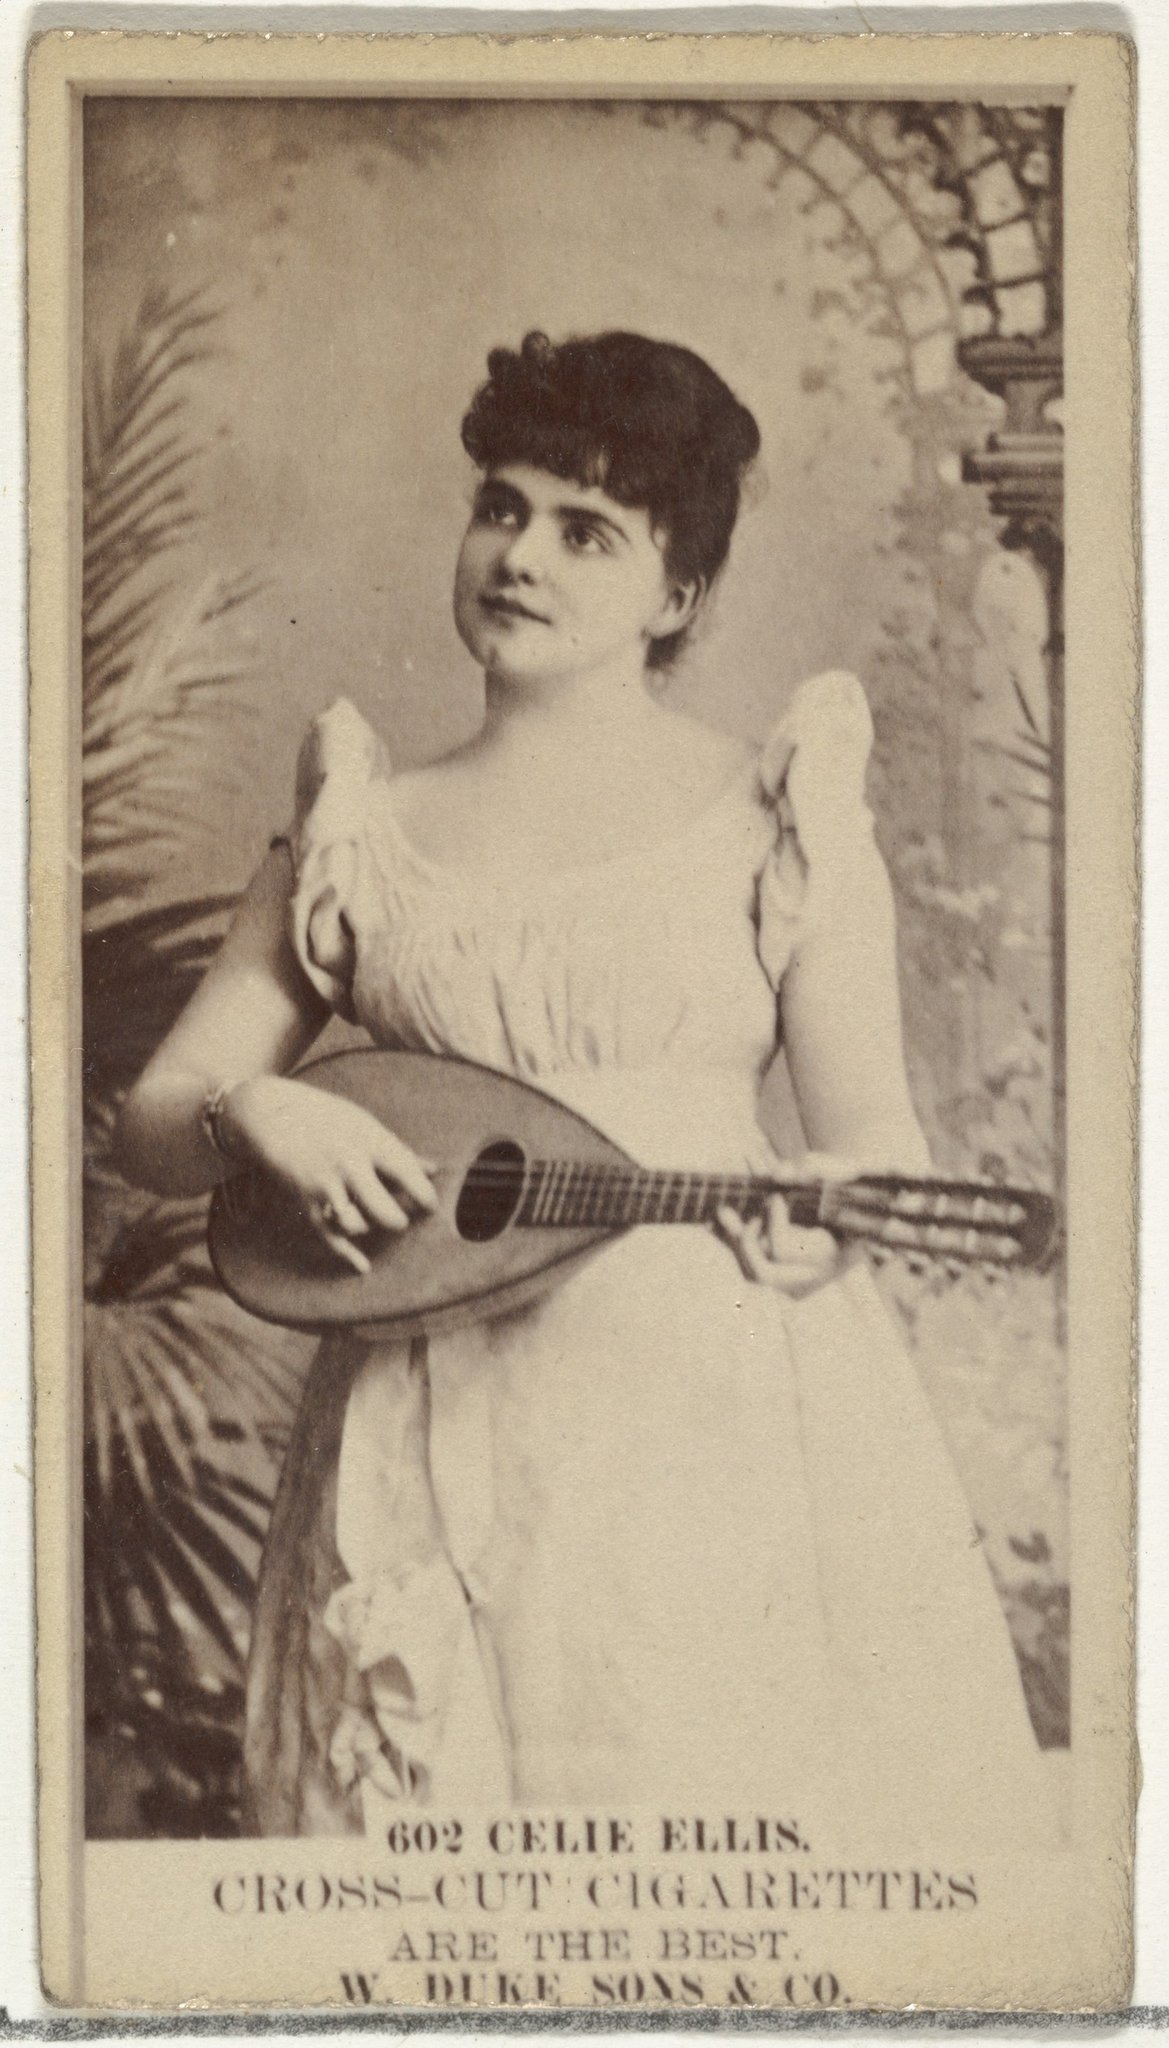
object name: photograph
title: Card Number 602, Celia Ellis, from the Actors and Actresses series (N145-3) issued by Duke Sons & Co. to promote Cross Cut Cigarettes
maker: w. duke, sons & co.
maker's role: publisher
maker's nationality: american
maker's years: 1870-1920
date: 1880-1889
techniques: albumen silver print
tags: musical instruments,portraits,women,actresses